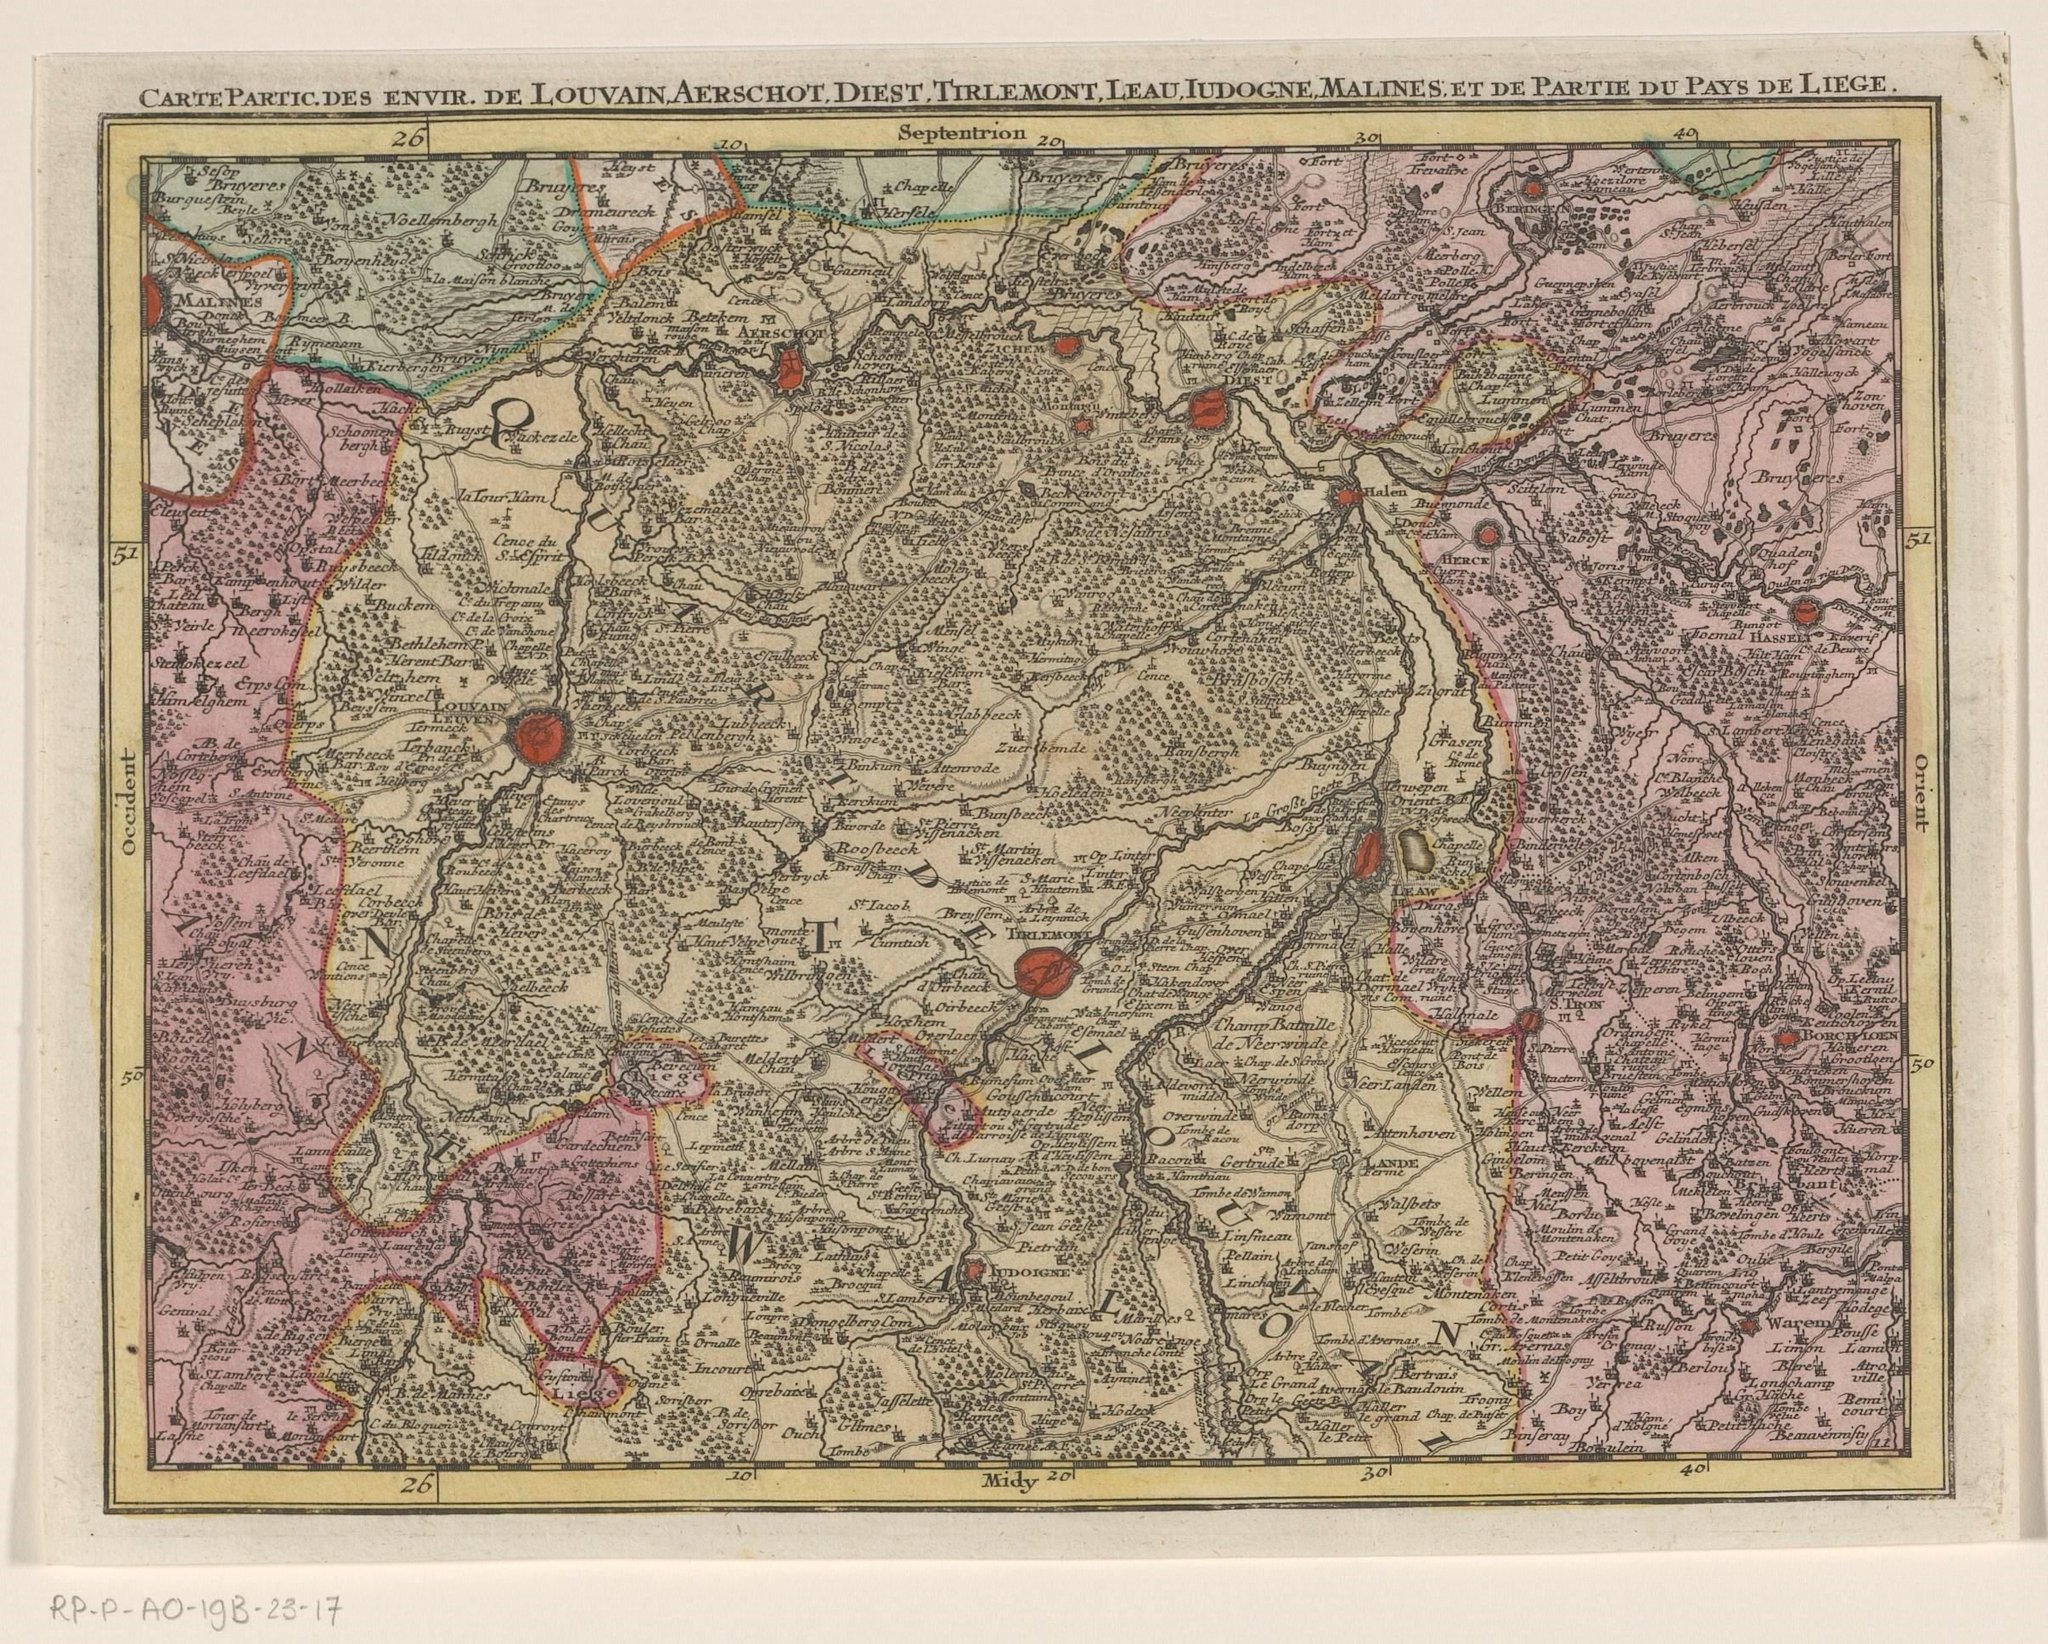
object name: print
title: Deel van een kaart van de Oostenrijkse Nederlanden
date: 1737-1757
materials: paper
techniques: engraving, hand coloring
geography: augsburg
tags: maps of separate countries or regions, southern netherlands, belgium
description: Deze kaart is onderdeel van een wandkaart van de Oostenrijkse Nederlanden, bestaande uit vier rijen van zes delen. De delen van de kaart zijn rechtsonder genummerd, beginnend bij het deel linksboven (1) tot het deel rechtsonder (24).